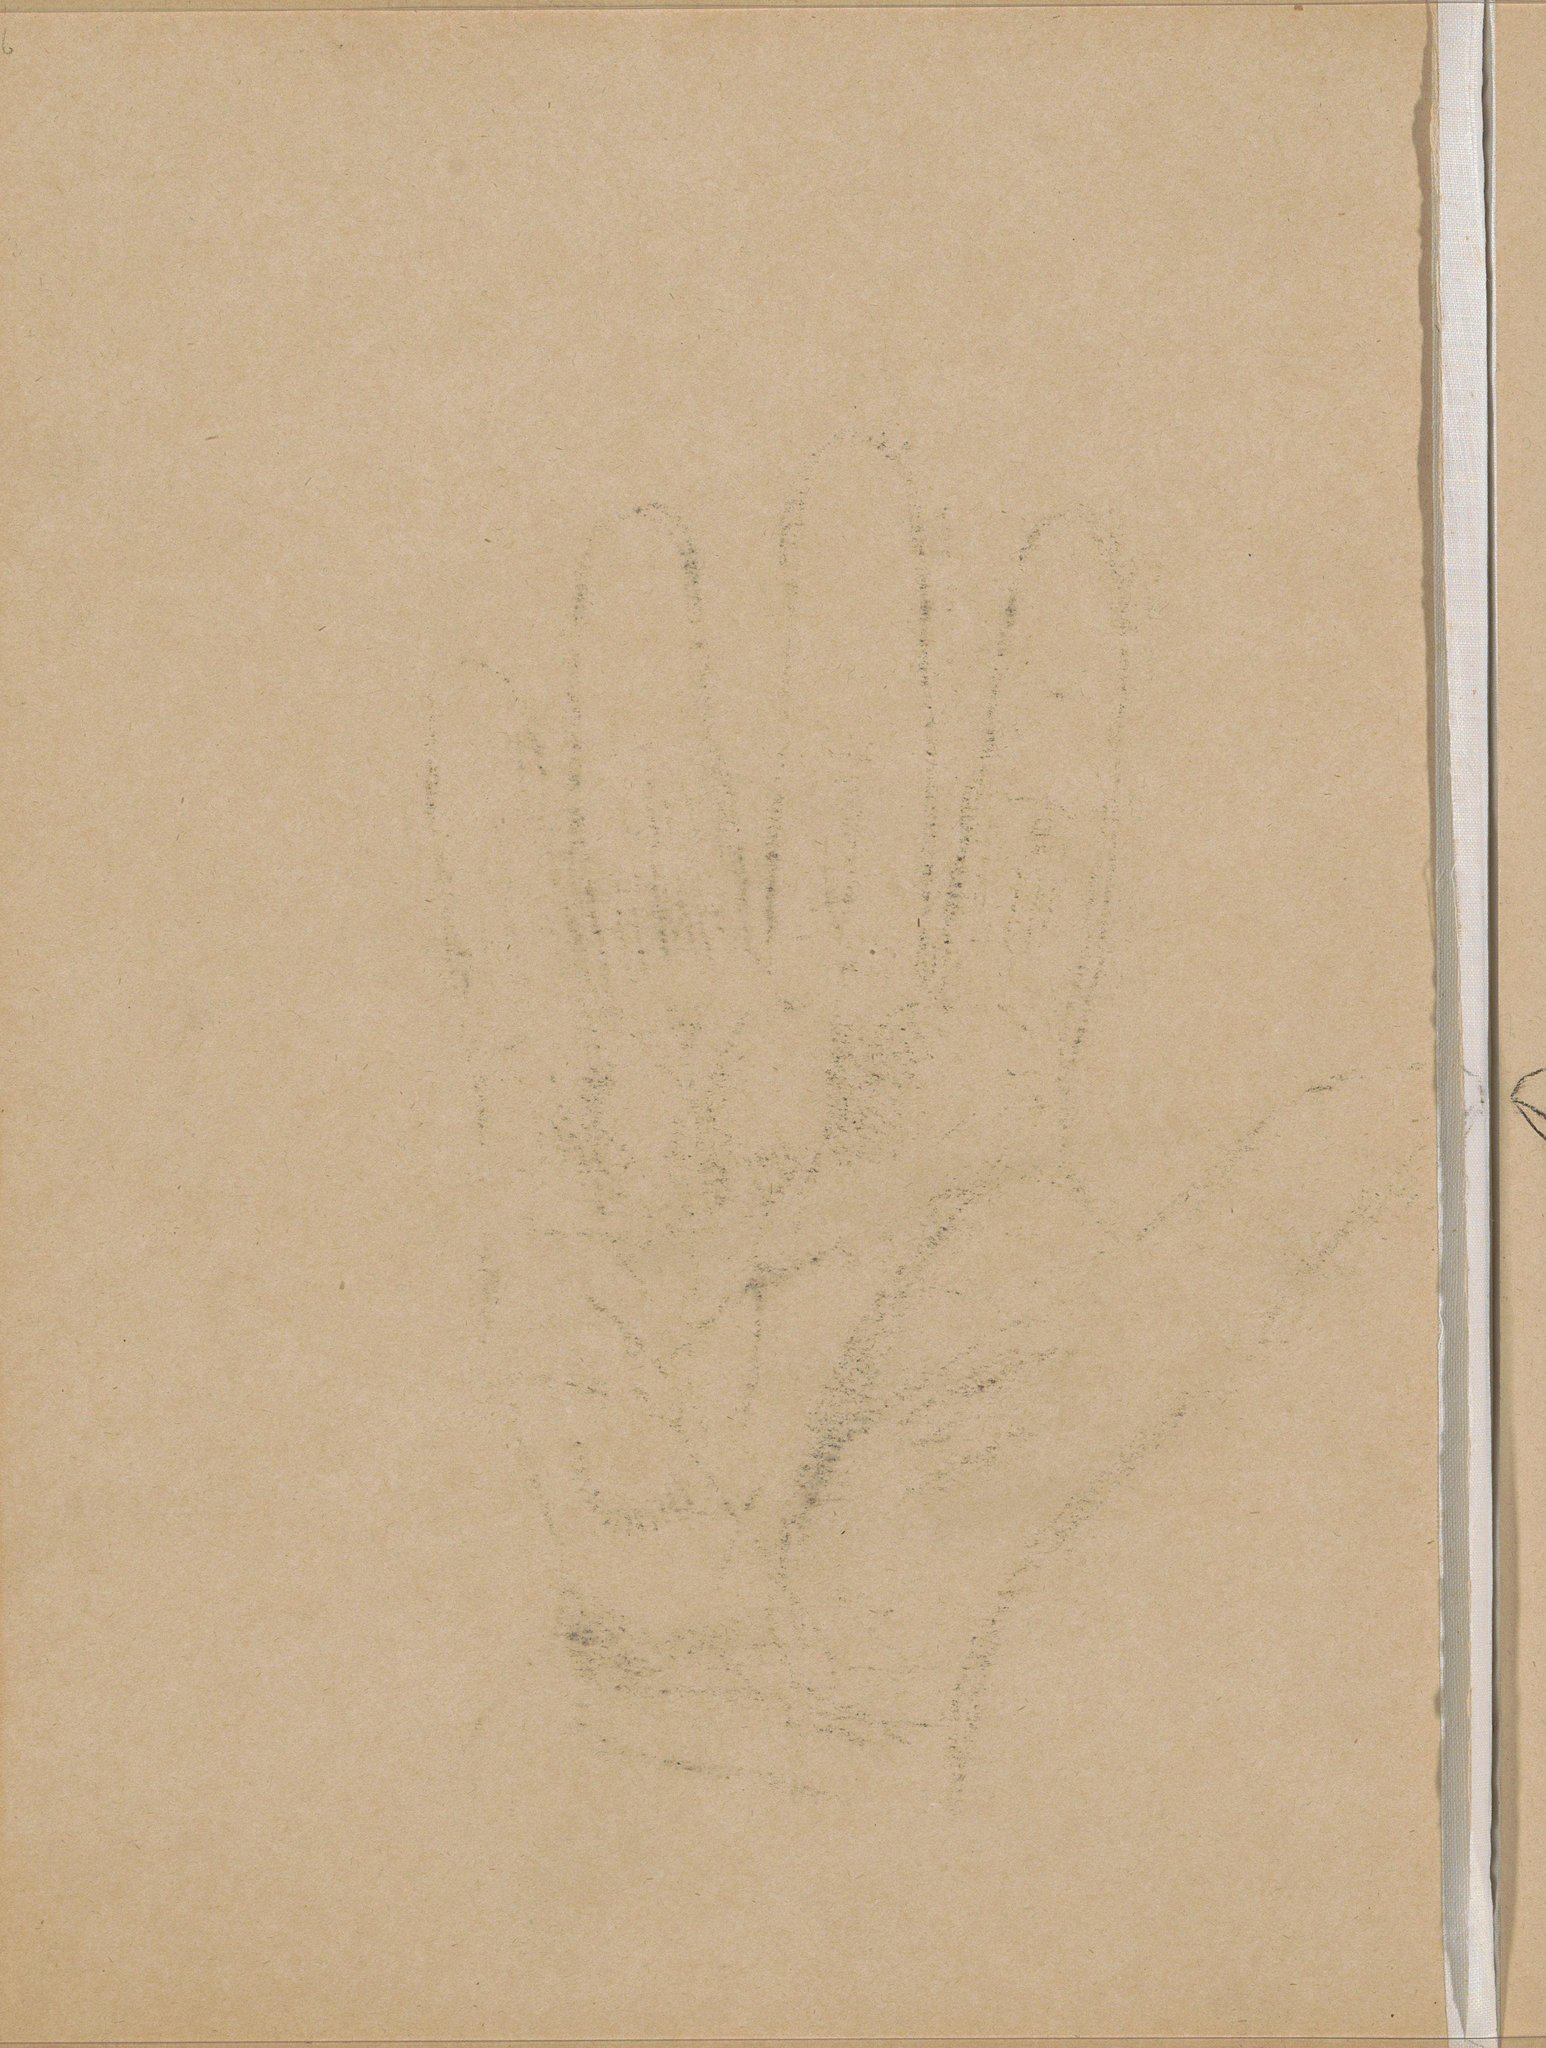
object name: sketchbook leaf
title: Abklatsch van de krijttekening op pagina 17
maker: willem witsen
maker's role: draughtsman, painter, print maker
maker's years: 1860-1923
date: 1874-1923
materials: paper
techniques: printmaking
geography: ewijkshoeve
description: Pagina 16 uit een schetsboek met 72 bladen.